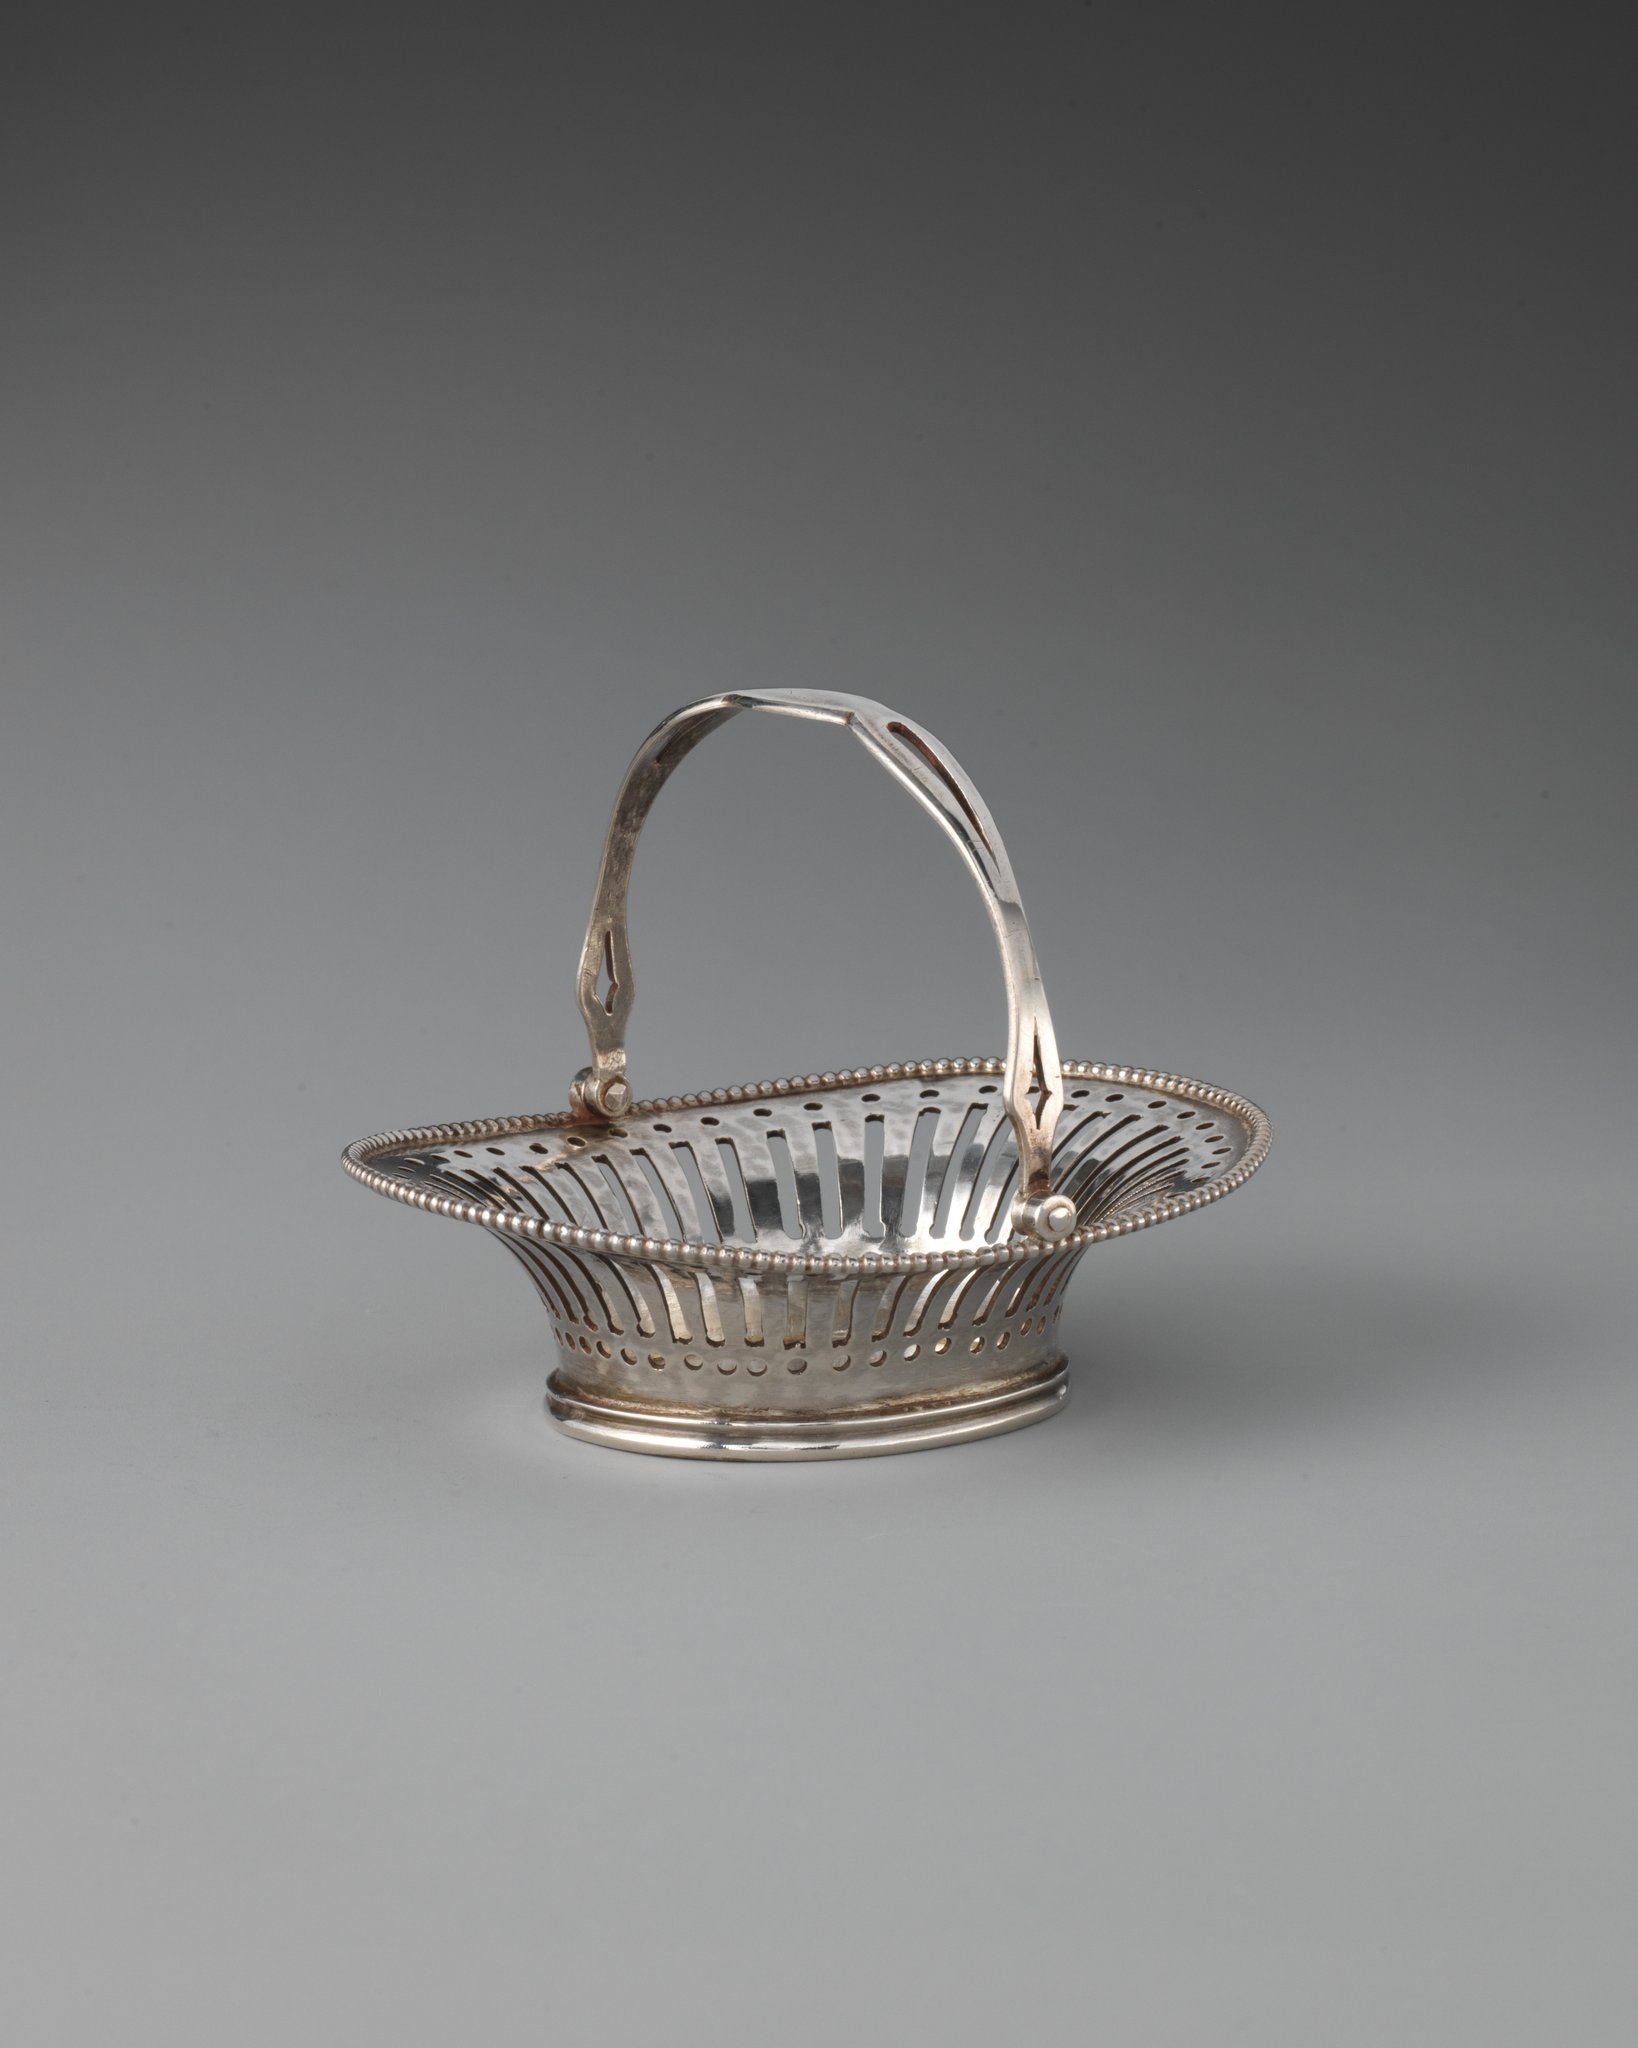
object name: cake basket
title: Miniature cake basket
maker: nicolas hearnden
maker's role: maker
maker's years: 1773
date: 1799-1800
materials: silver